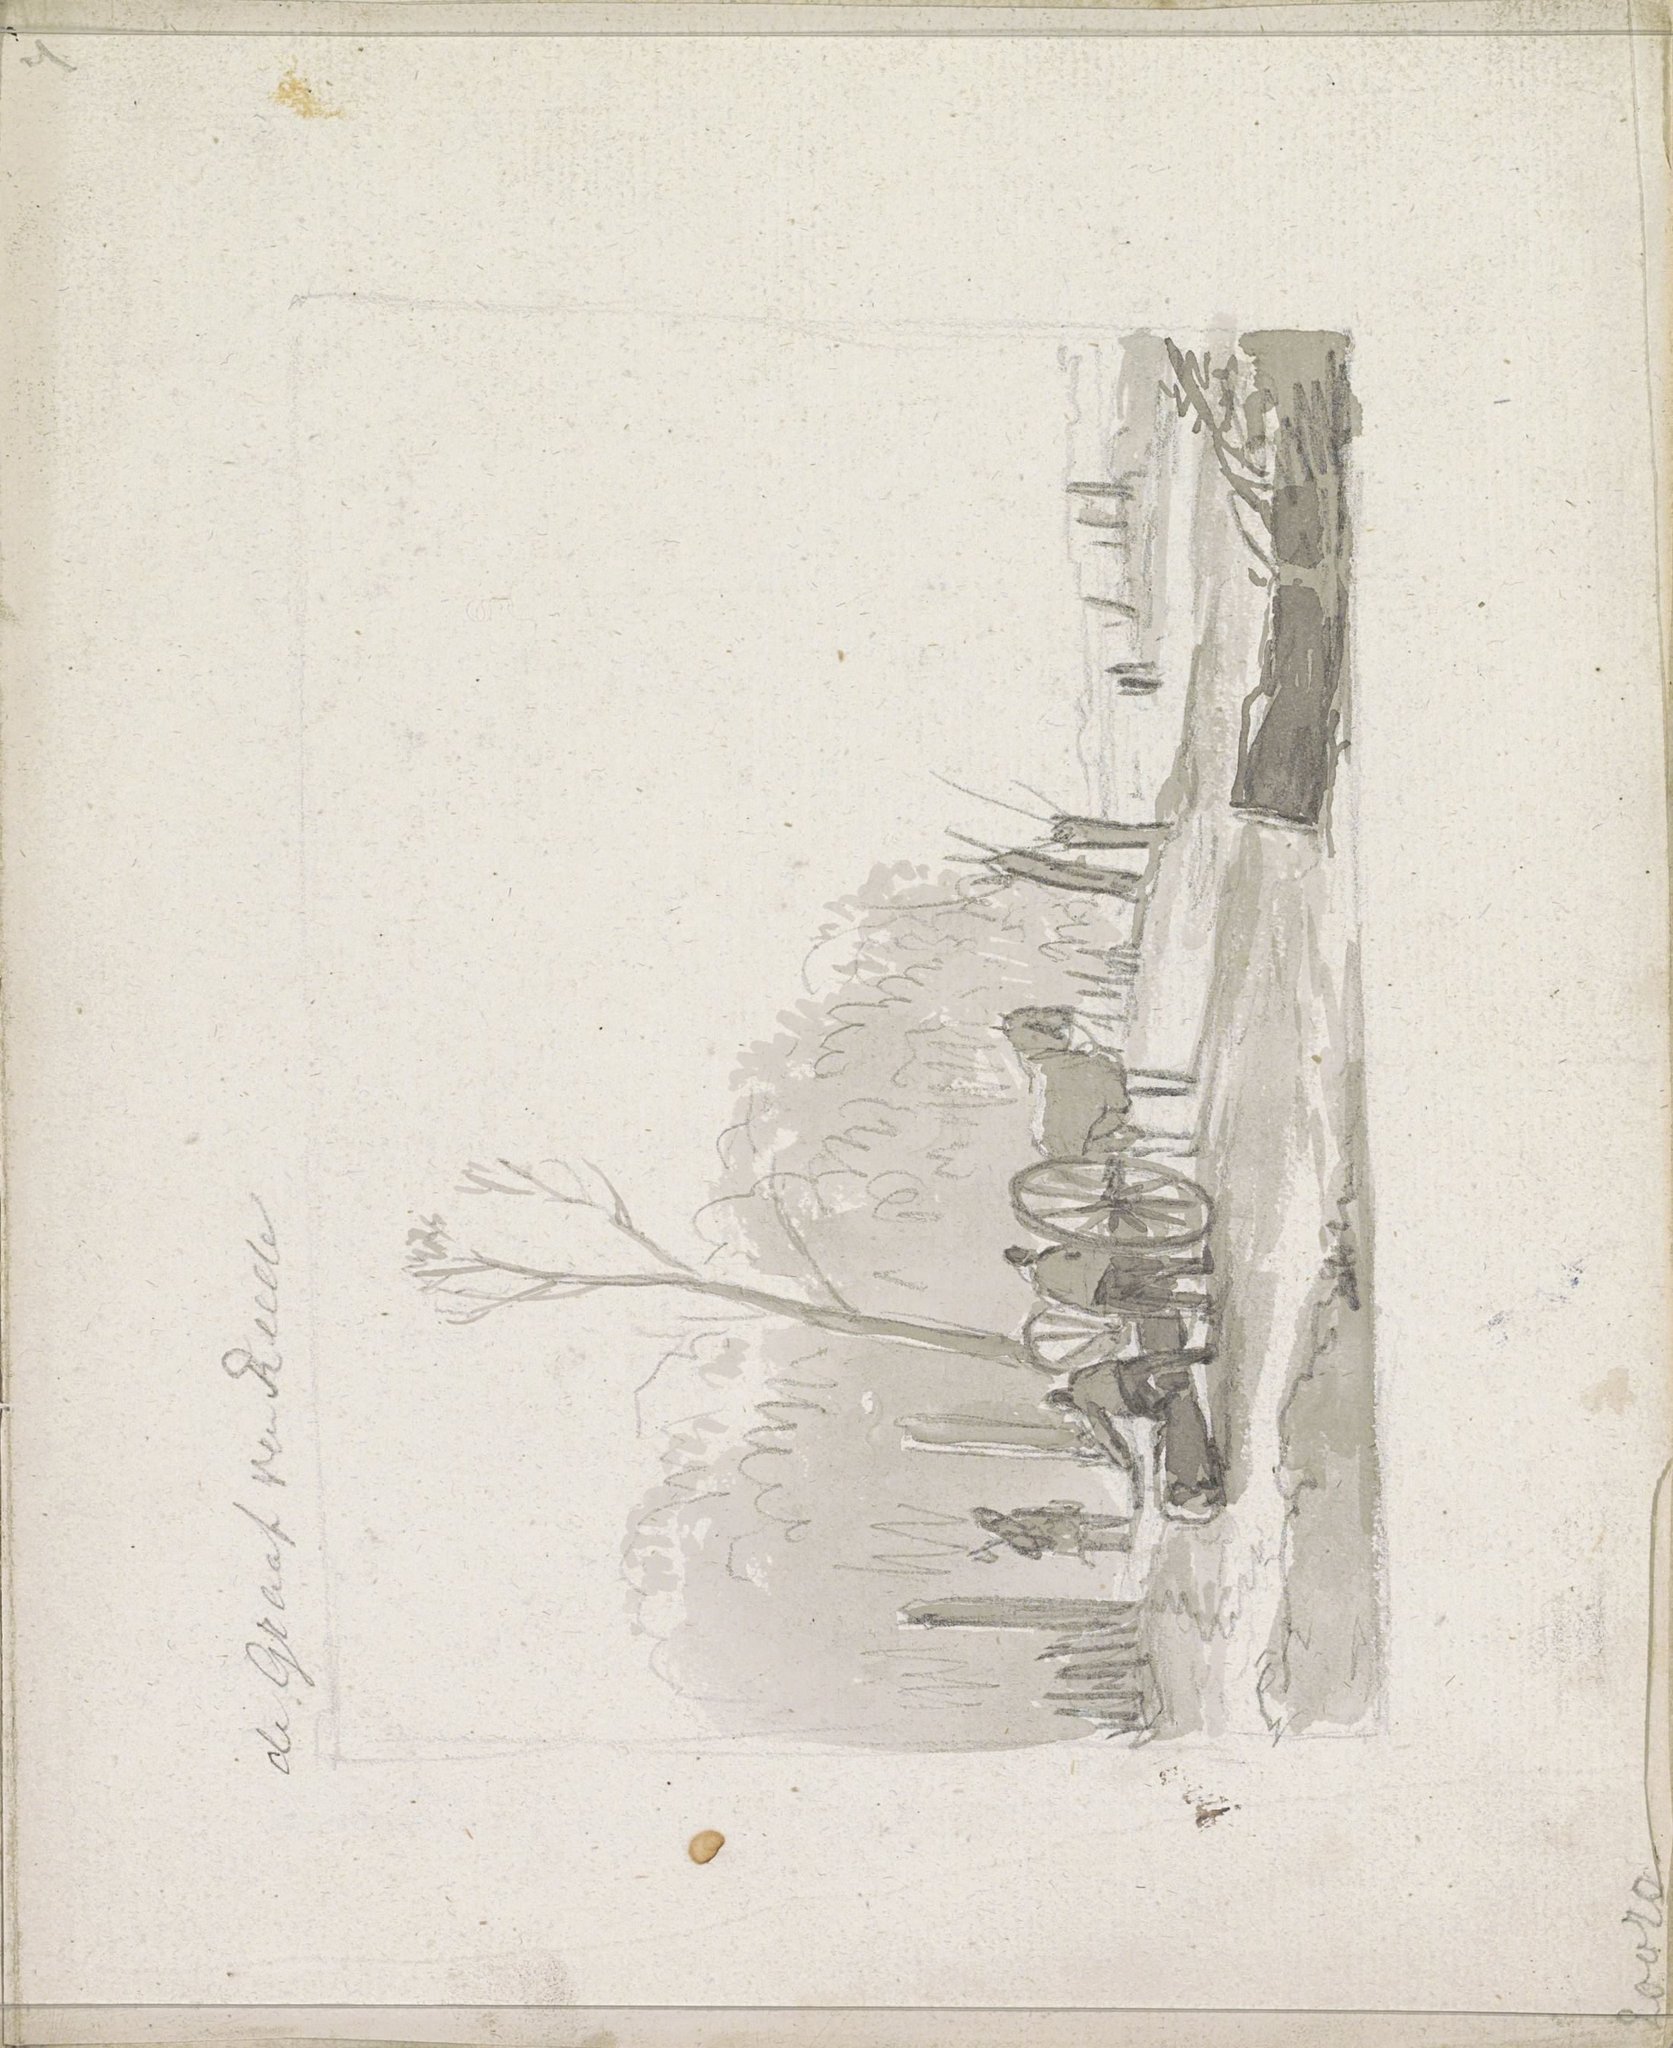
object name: sketchbook leaf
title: Landschap met een paard die een boomstam wegsleept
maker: andreas schelfhout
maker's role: draughtsman, painter, print maker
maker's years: 1787-1870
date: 1825-1829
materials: paper, pencil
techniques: brush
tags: animal traction, animal-drawn vehicle (carriage etc.), landscapes (+ landscape with figures, staffage)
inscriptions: annotation: ‘de Graaf van Reede’, number: ‘7/20070’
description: Bij het paard staan figuren aan de rand van een bos. Blad 11 recto uit een schetsboek met 95 bladen.